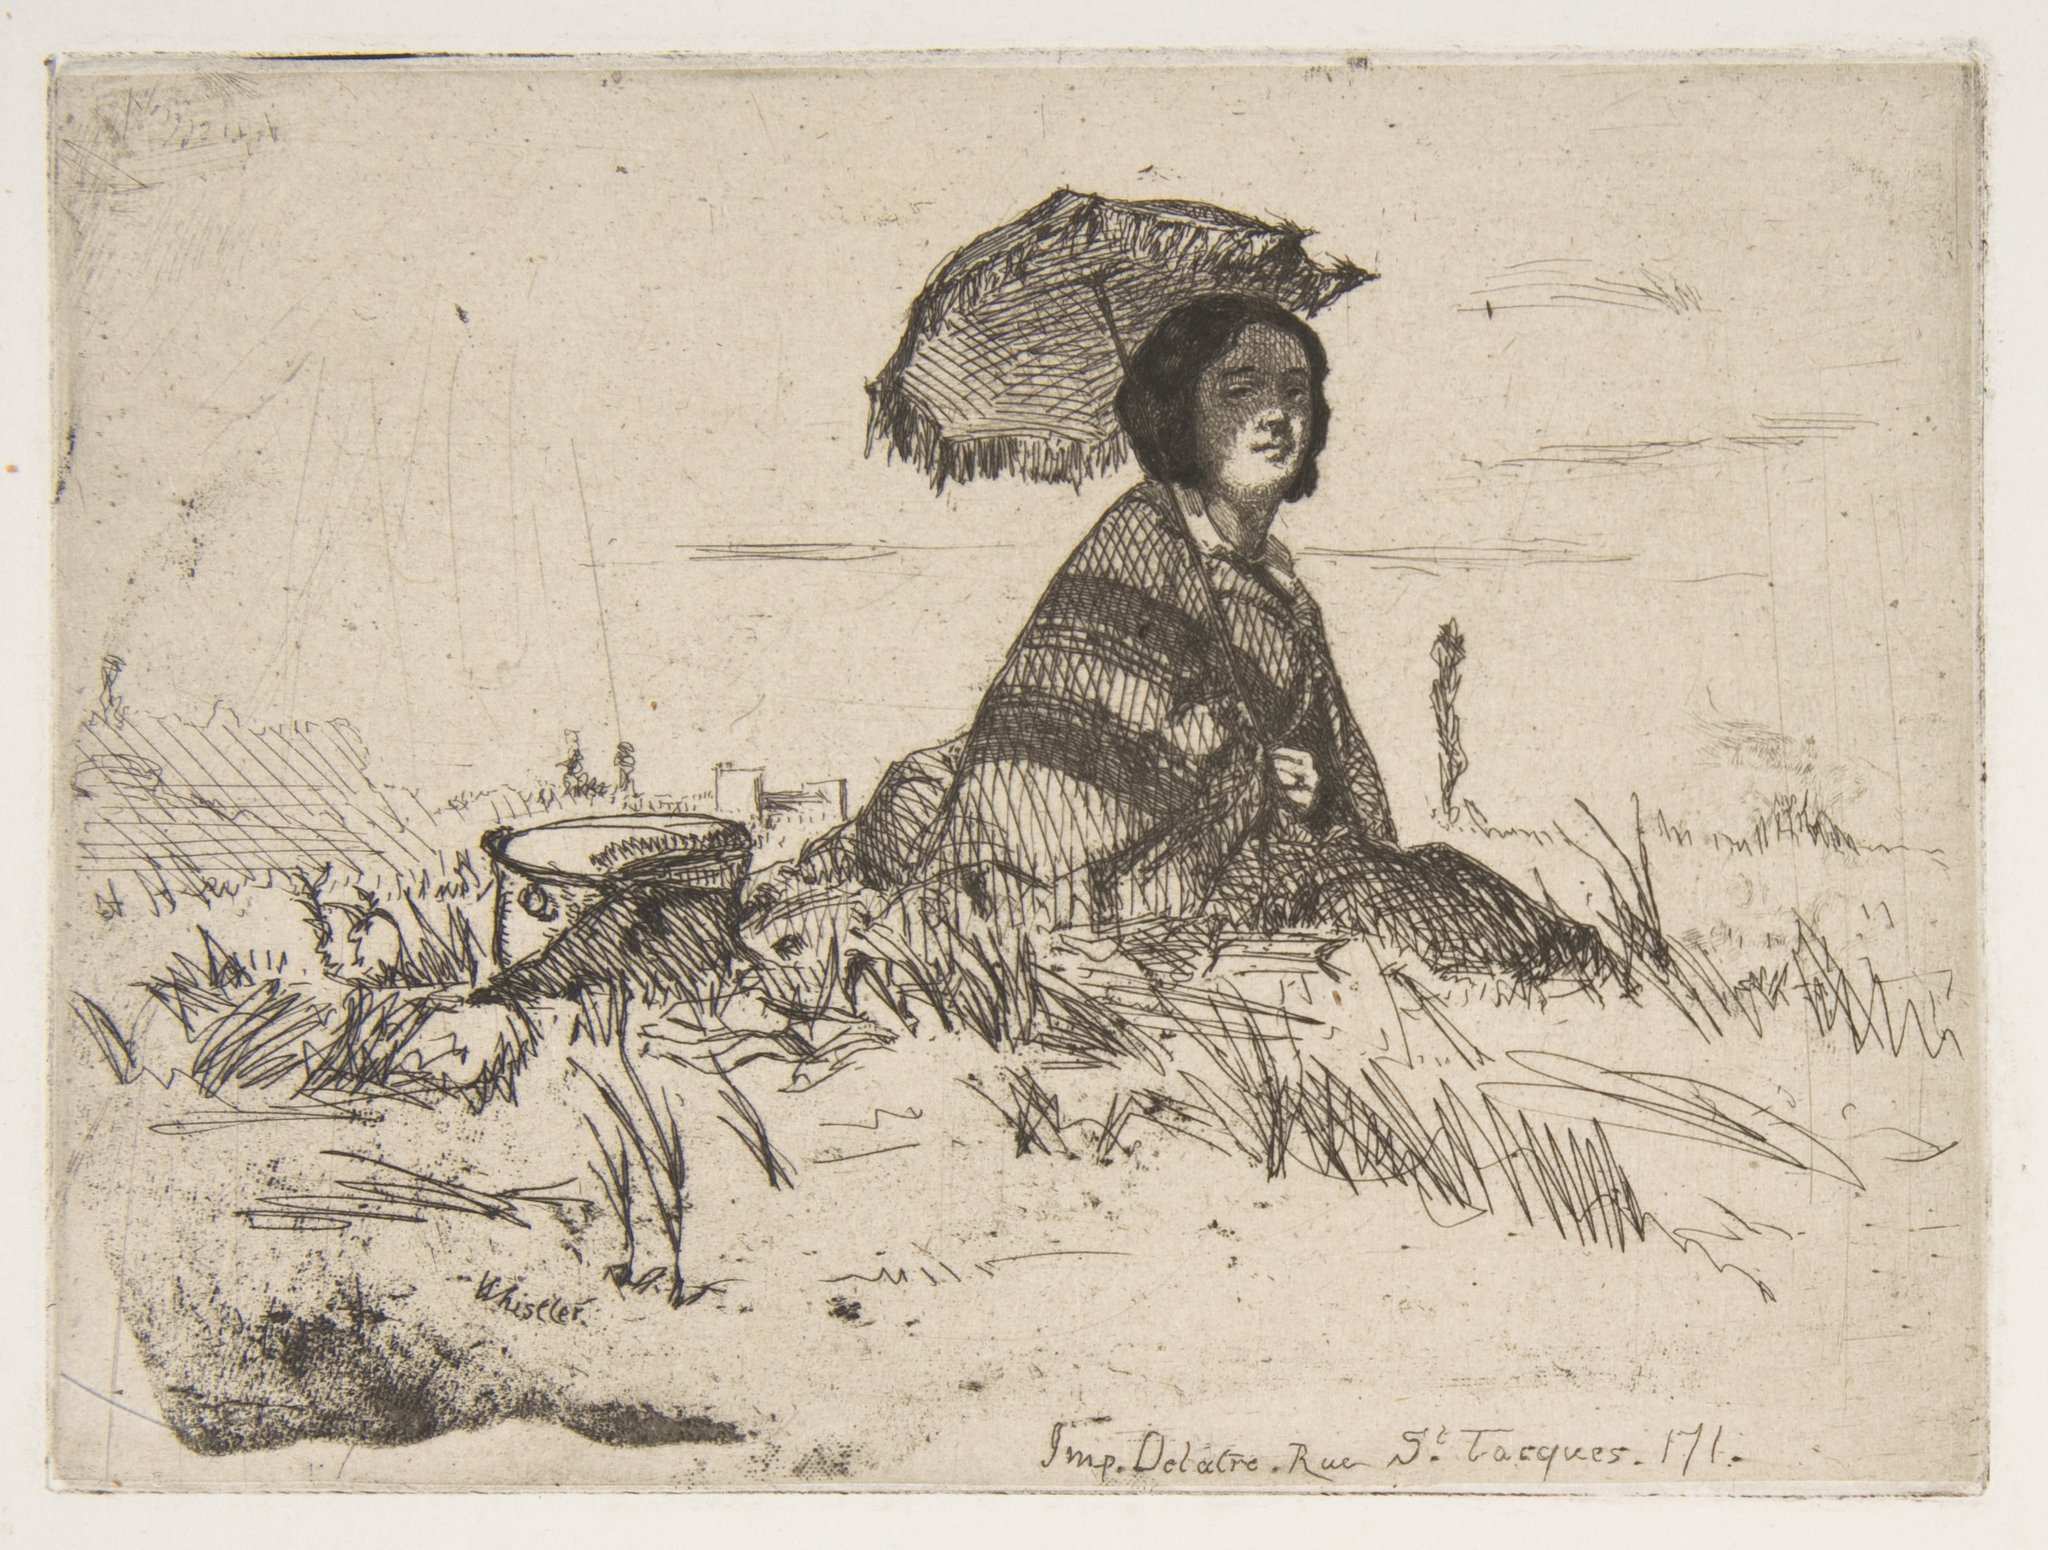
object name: print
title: En plein soleil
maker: james mcneill whistler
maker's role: artist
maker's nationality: american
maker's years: 1834-1903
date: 1858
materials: chine, ink, paper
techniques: printmaking, etching, printing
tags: women,parasols